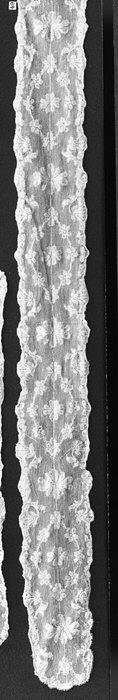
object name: barbe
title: Barbe (one of three pieces)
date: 1701-1800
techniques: lace